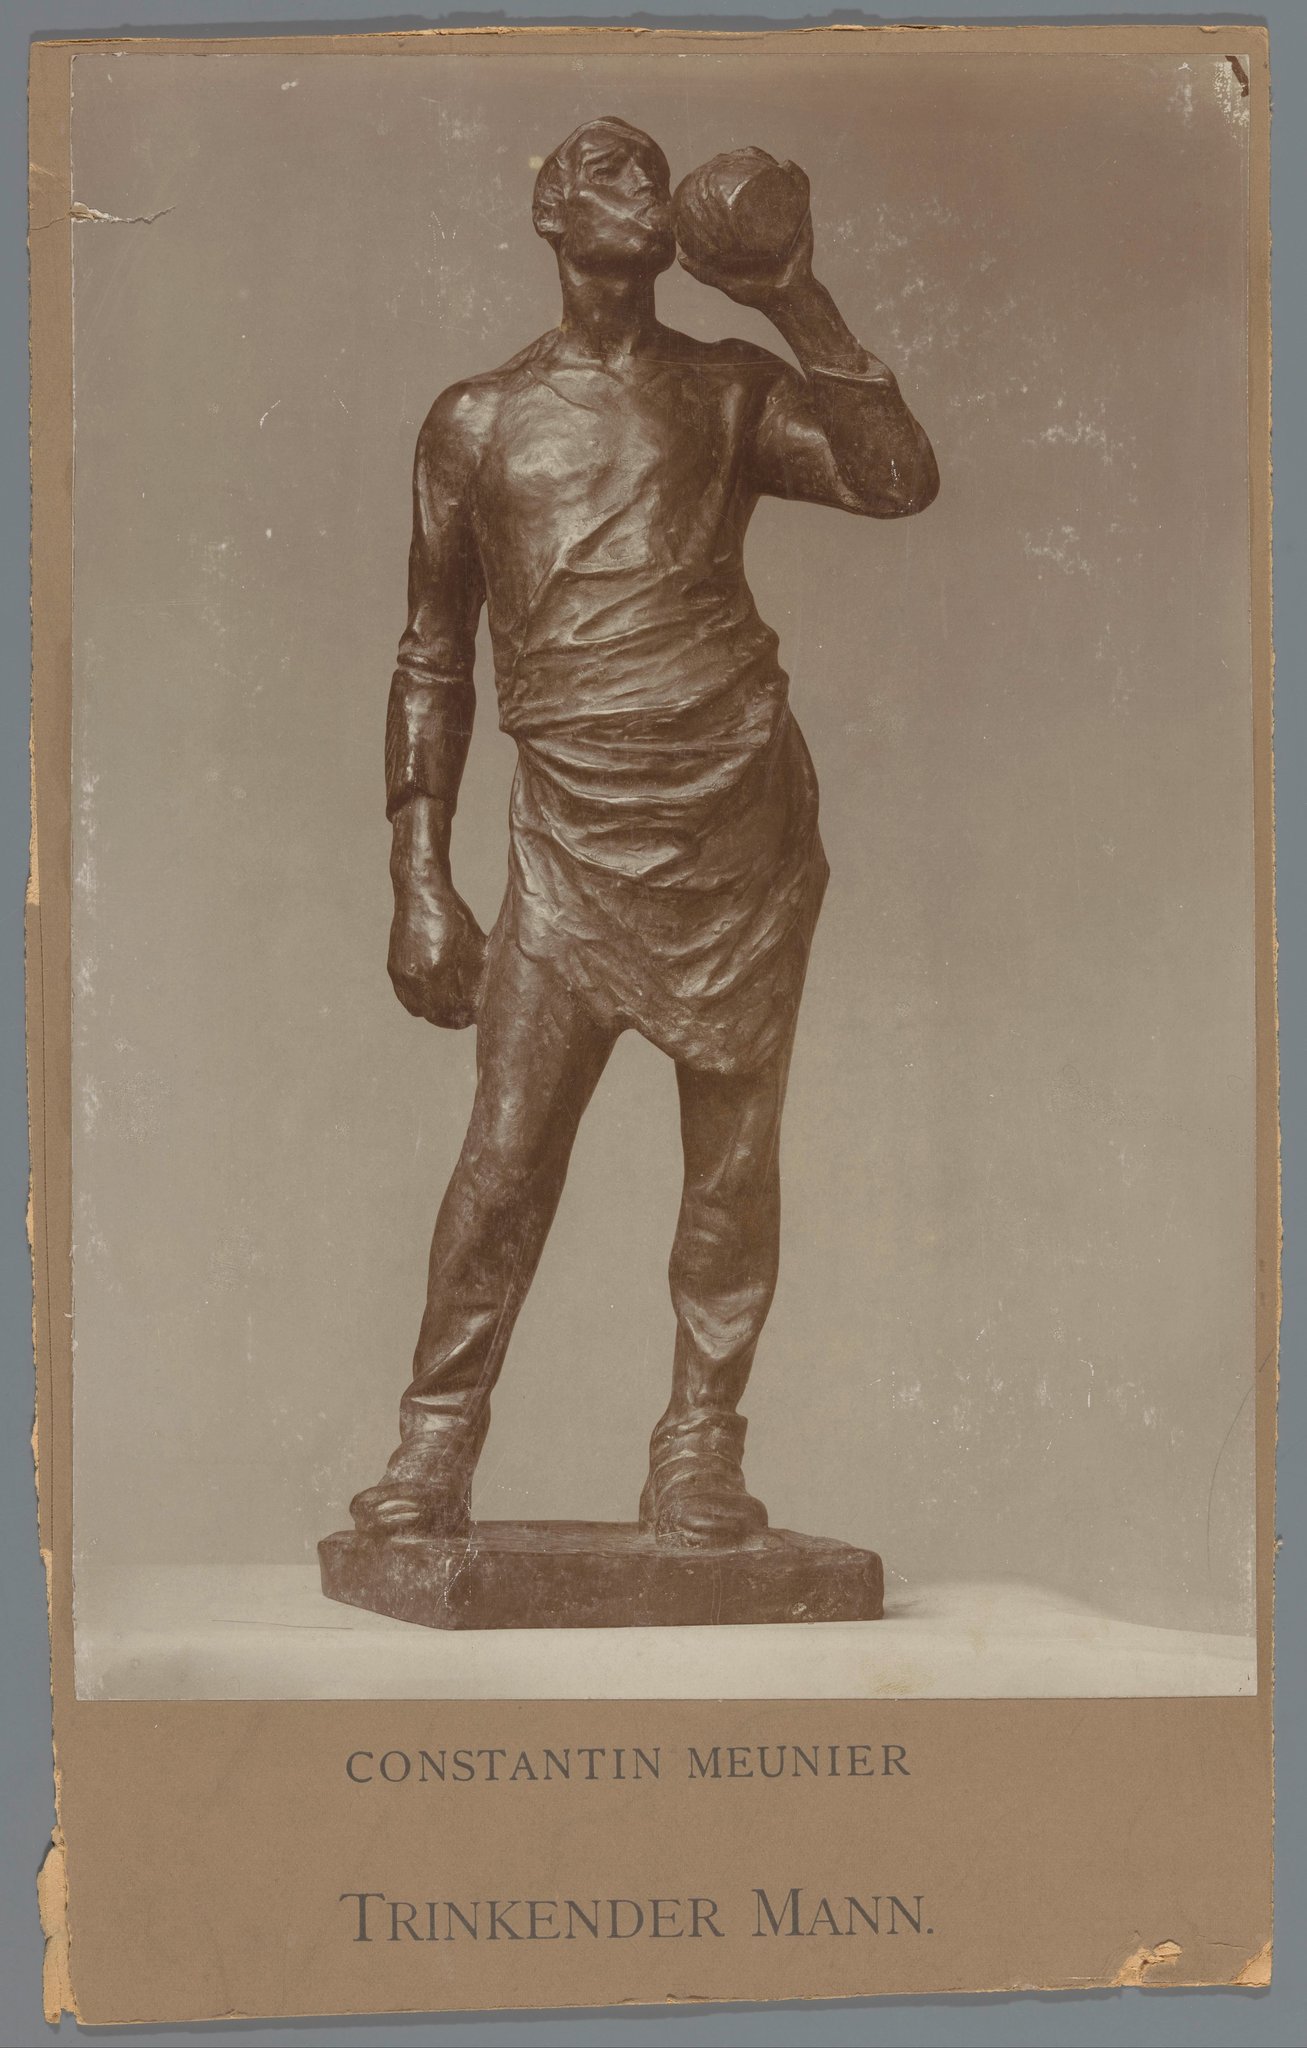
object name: photograph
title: Beeld van C. Meunier, getiteld 'Drinkende Man'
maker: Anonymous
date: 1890-1900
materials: cardboard, photographic support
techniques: daylight paper print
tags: sculpture, drinking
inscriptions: collector's mark: Lugt 3937